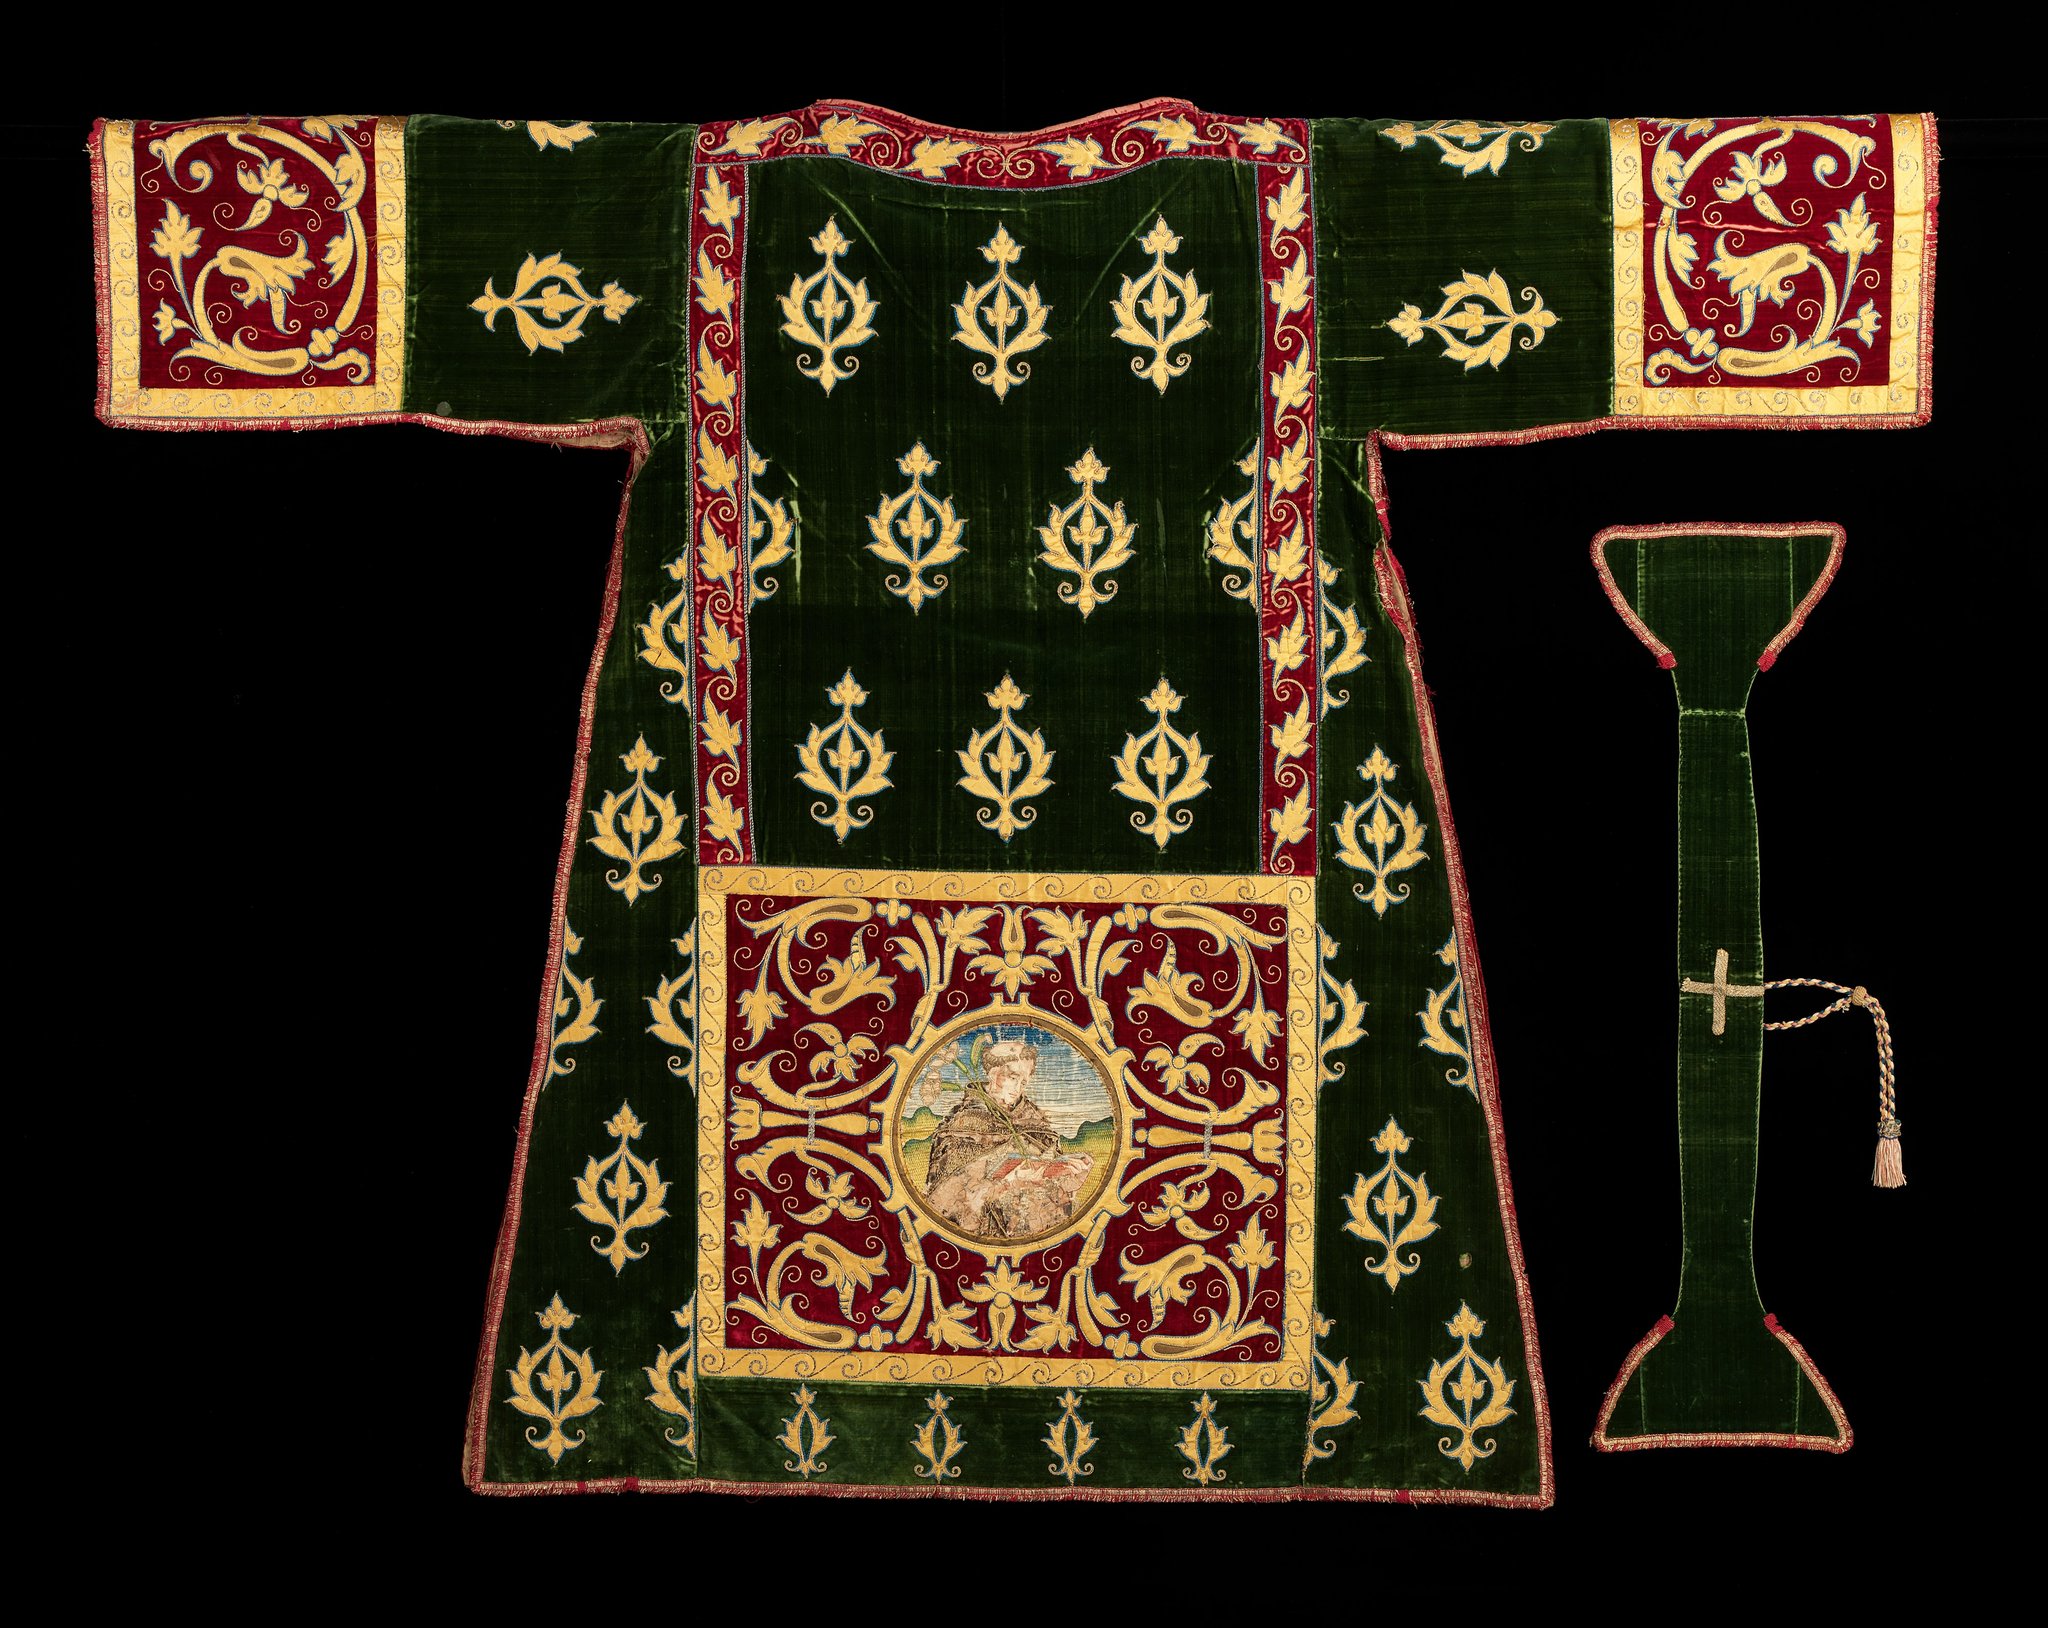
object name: vestment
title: Dalmatic and maniple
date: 1676-1700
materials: linen, metal, silk